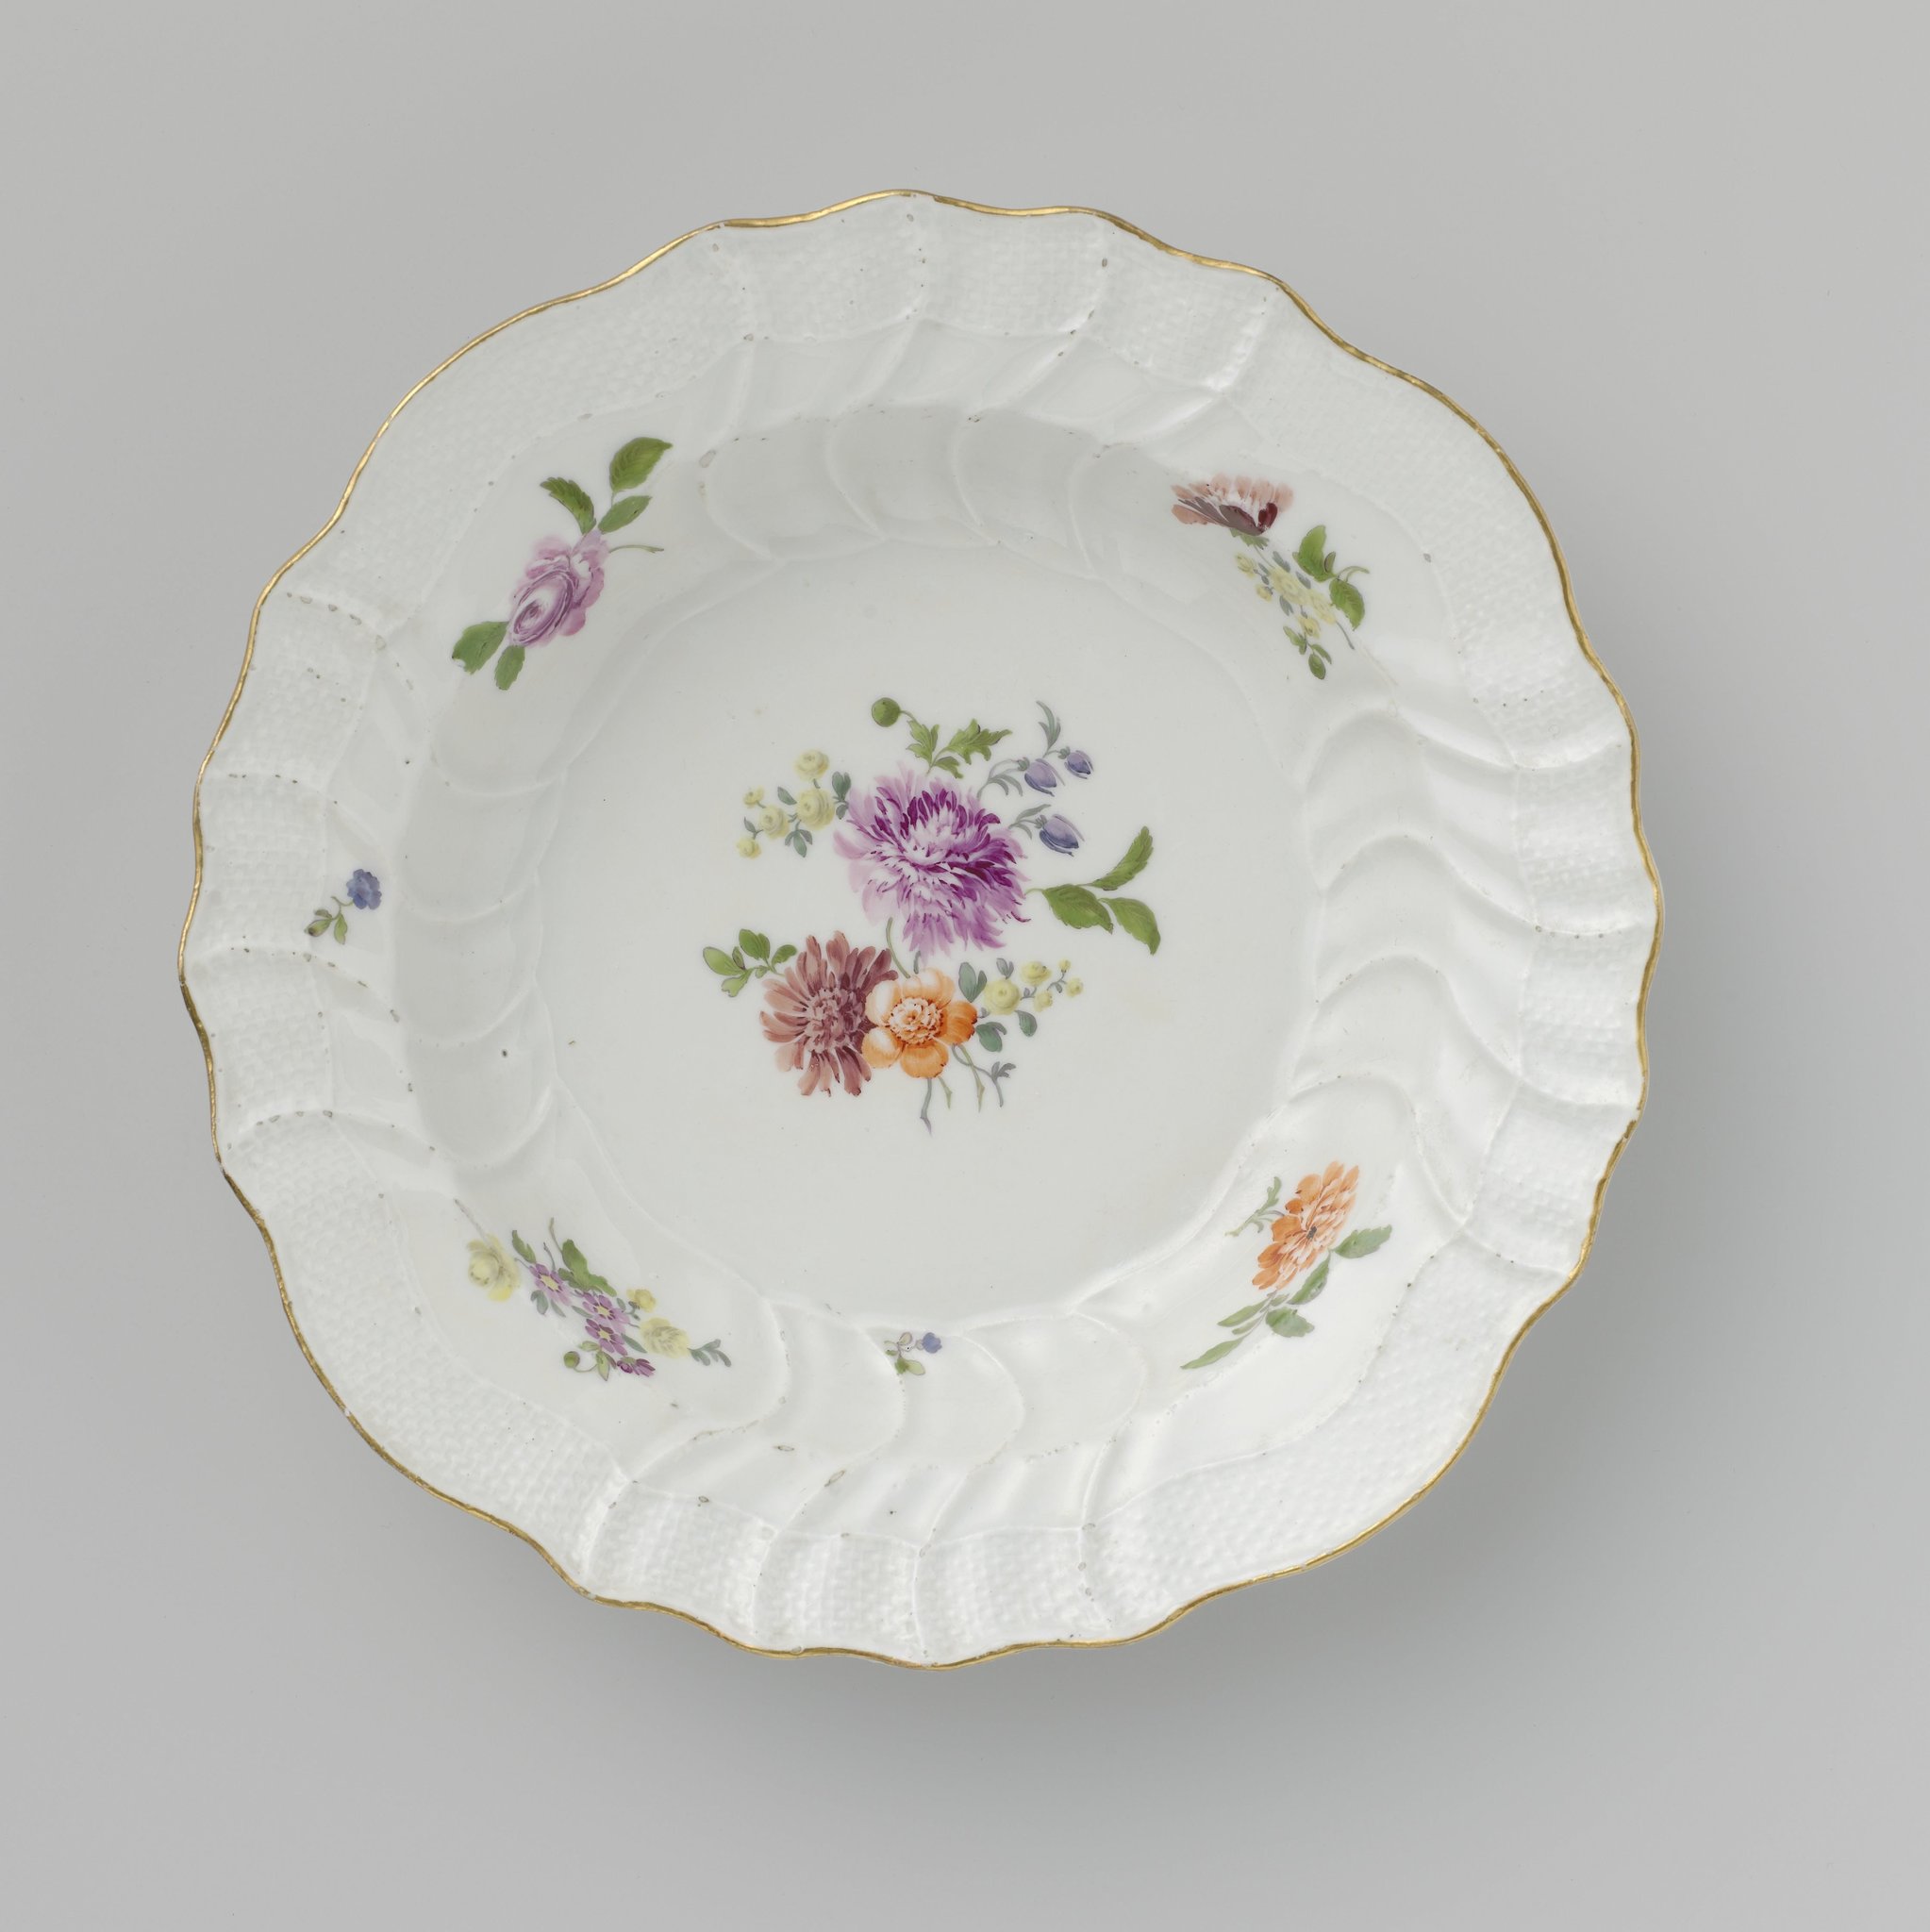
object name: eating drinking utensil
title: Bord, veelkleurig beschilderd met Deutsche Blumen, insekten en vruchten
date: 1750-1760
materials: porcelain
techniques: painted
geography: meissen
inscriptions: factory mark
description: Rond soepbord van beschilderd porselein. Het bord is beschilderd met Deutsche Blumen, insekten en vruchten. De rand is in reliëf versierd met het Neuozier-patroon. Het bord is gemerkt en hoort bij een servies (BK-17474-1 t/m BK-17474-253).